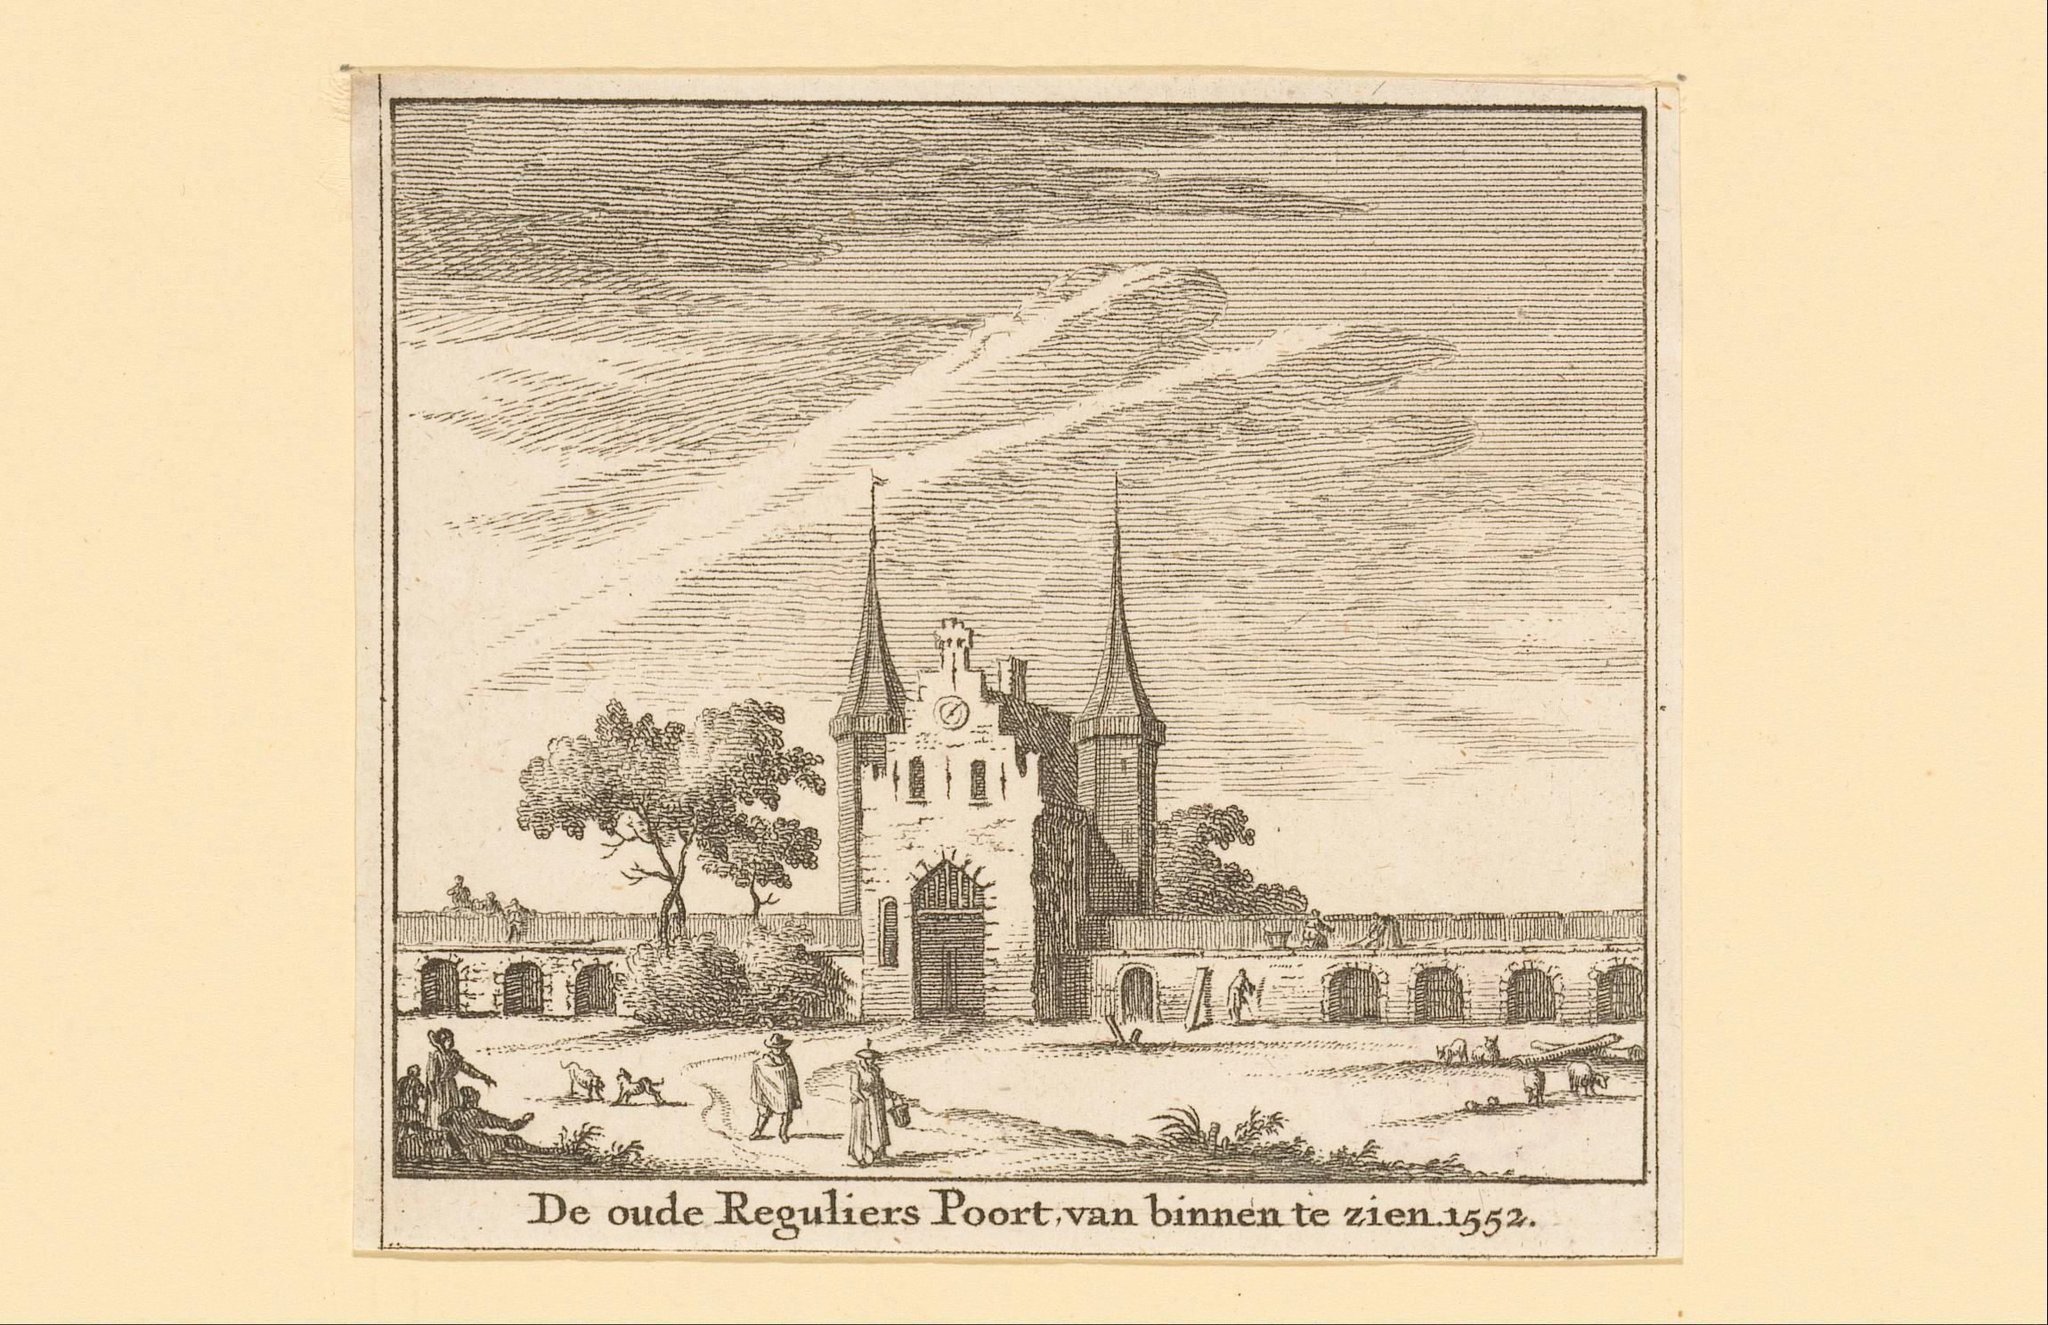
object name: print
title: De oude Reguliers Poort, van binnen te zien. 1552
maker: jan goeree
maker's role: draughtsman, print maker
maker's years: 1670-1731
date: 1723-1738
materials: paper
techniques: engraving, etching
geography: amsterdam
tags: city-gate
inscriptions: collector's mark: Lugt 195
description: Prent ook gebruikt in: Willink, Daniël. Amsterdamsche Buitensingel nevens de omleggende dorpen, opgeheldert door aanteekeningen over veele voornaame geschiedeniszen: met afbeeldingen (…) / Daniël Willinks Amsterdamsche Buitensingel. Amsterdam: Andries van Damme, 1723. En in: Willink, Daniël. Amsterdamsche Buitensingel nevens de omleggende dorpen, opgeheldert door aanteekeningen over veele voornaame geschiedenissen: met afbeeldingen (…) / Daniël Willinks Amsterdamsche Buitensingel. Amsterdam: Arend van Huyssteen, 1738.